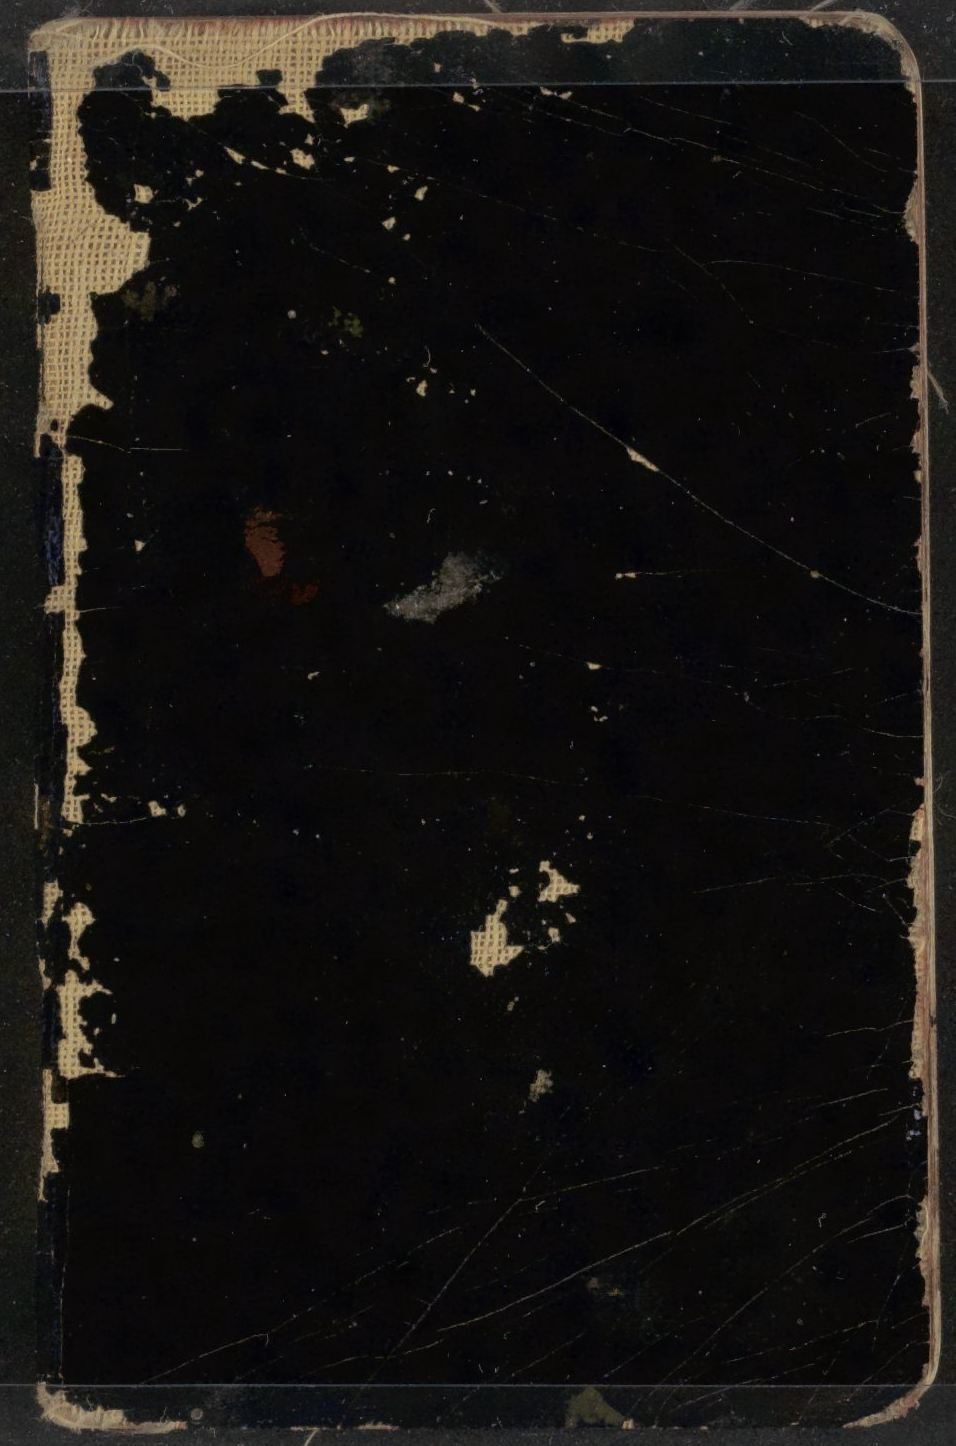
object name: sketchbook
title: Schetsboek met 30 bladen vervaardigd in Amsterdam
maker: george hendrik breitner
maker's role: draughtsman, painter, print maker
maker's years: 1857-1923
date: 1893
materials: chalk, pencil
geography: amsterdam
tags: adult woman, adult man, street, amsterdam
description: Schetsboek bestaande uit 30 bladen met voornamelijk figuurstudies en gezichten in Amsterdam.